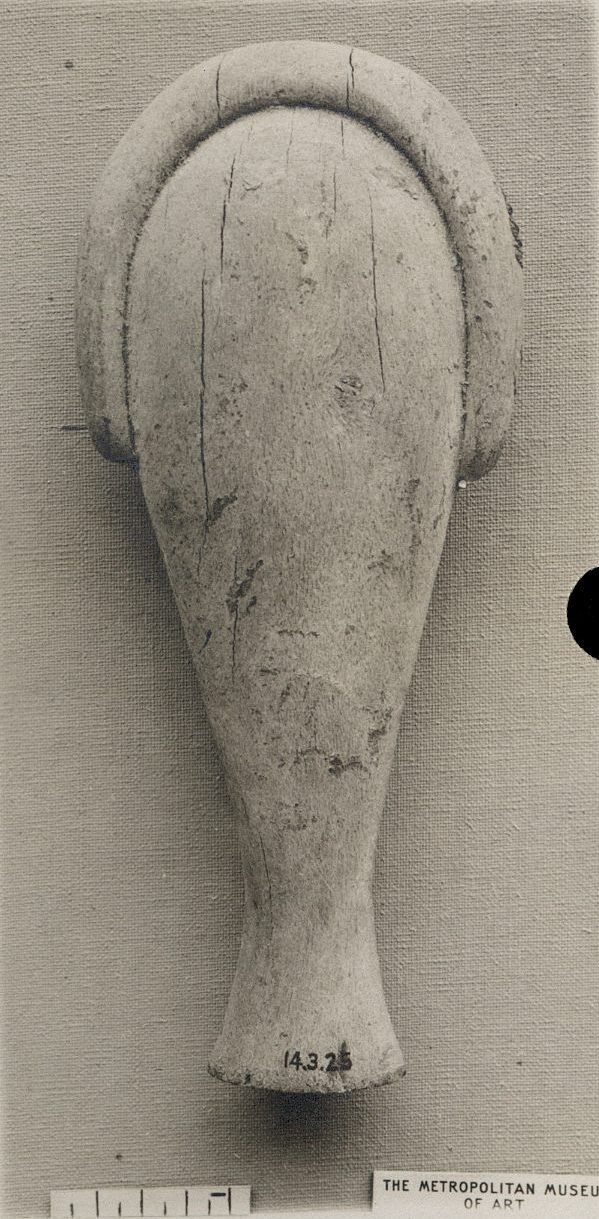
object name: bat amulet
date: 1859-1640 BCE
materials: paint, wood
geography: egypt